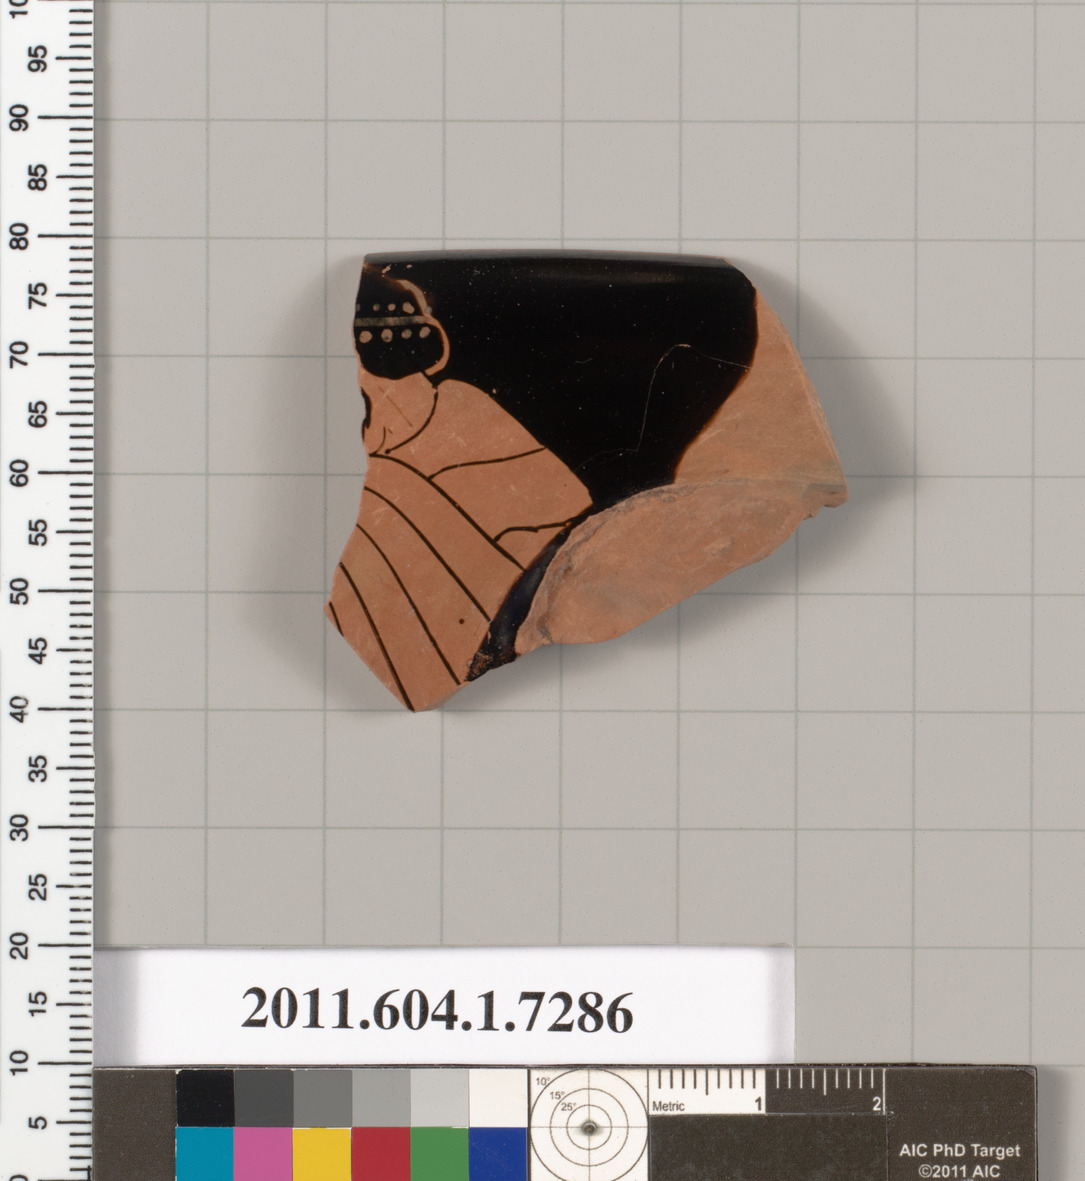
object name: kylix fragment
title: Terracotta rim fragment of a kylix (drinking cup)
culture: greek, attic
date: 500-480 BCE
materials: terracotta